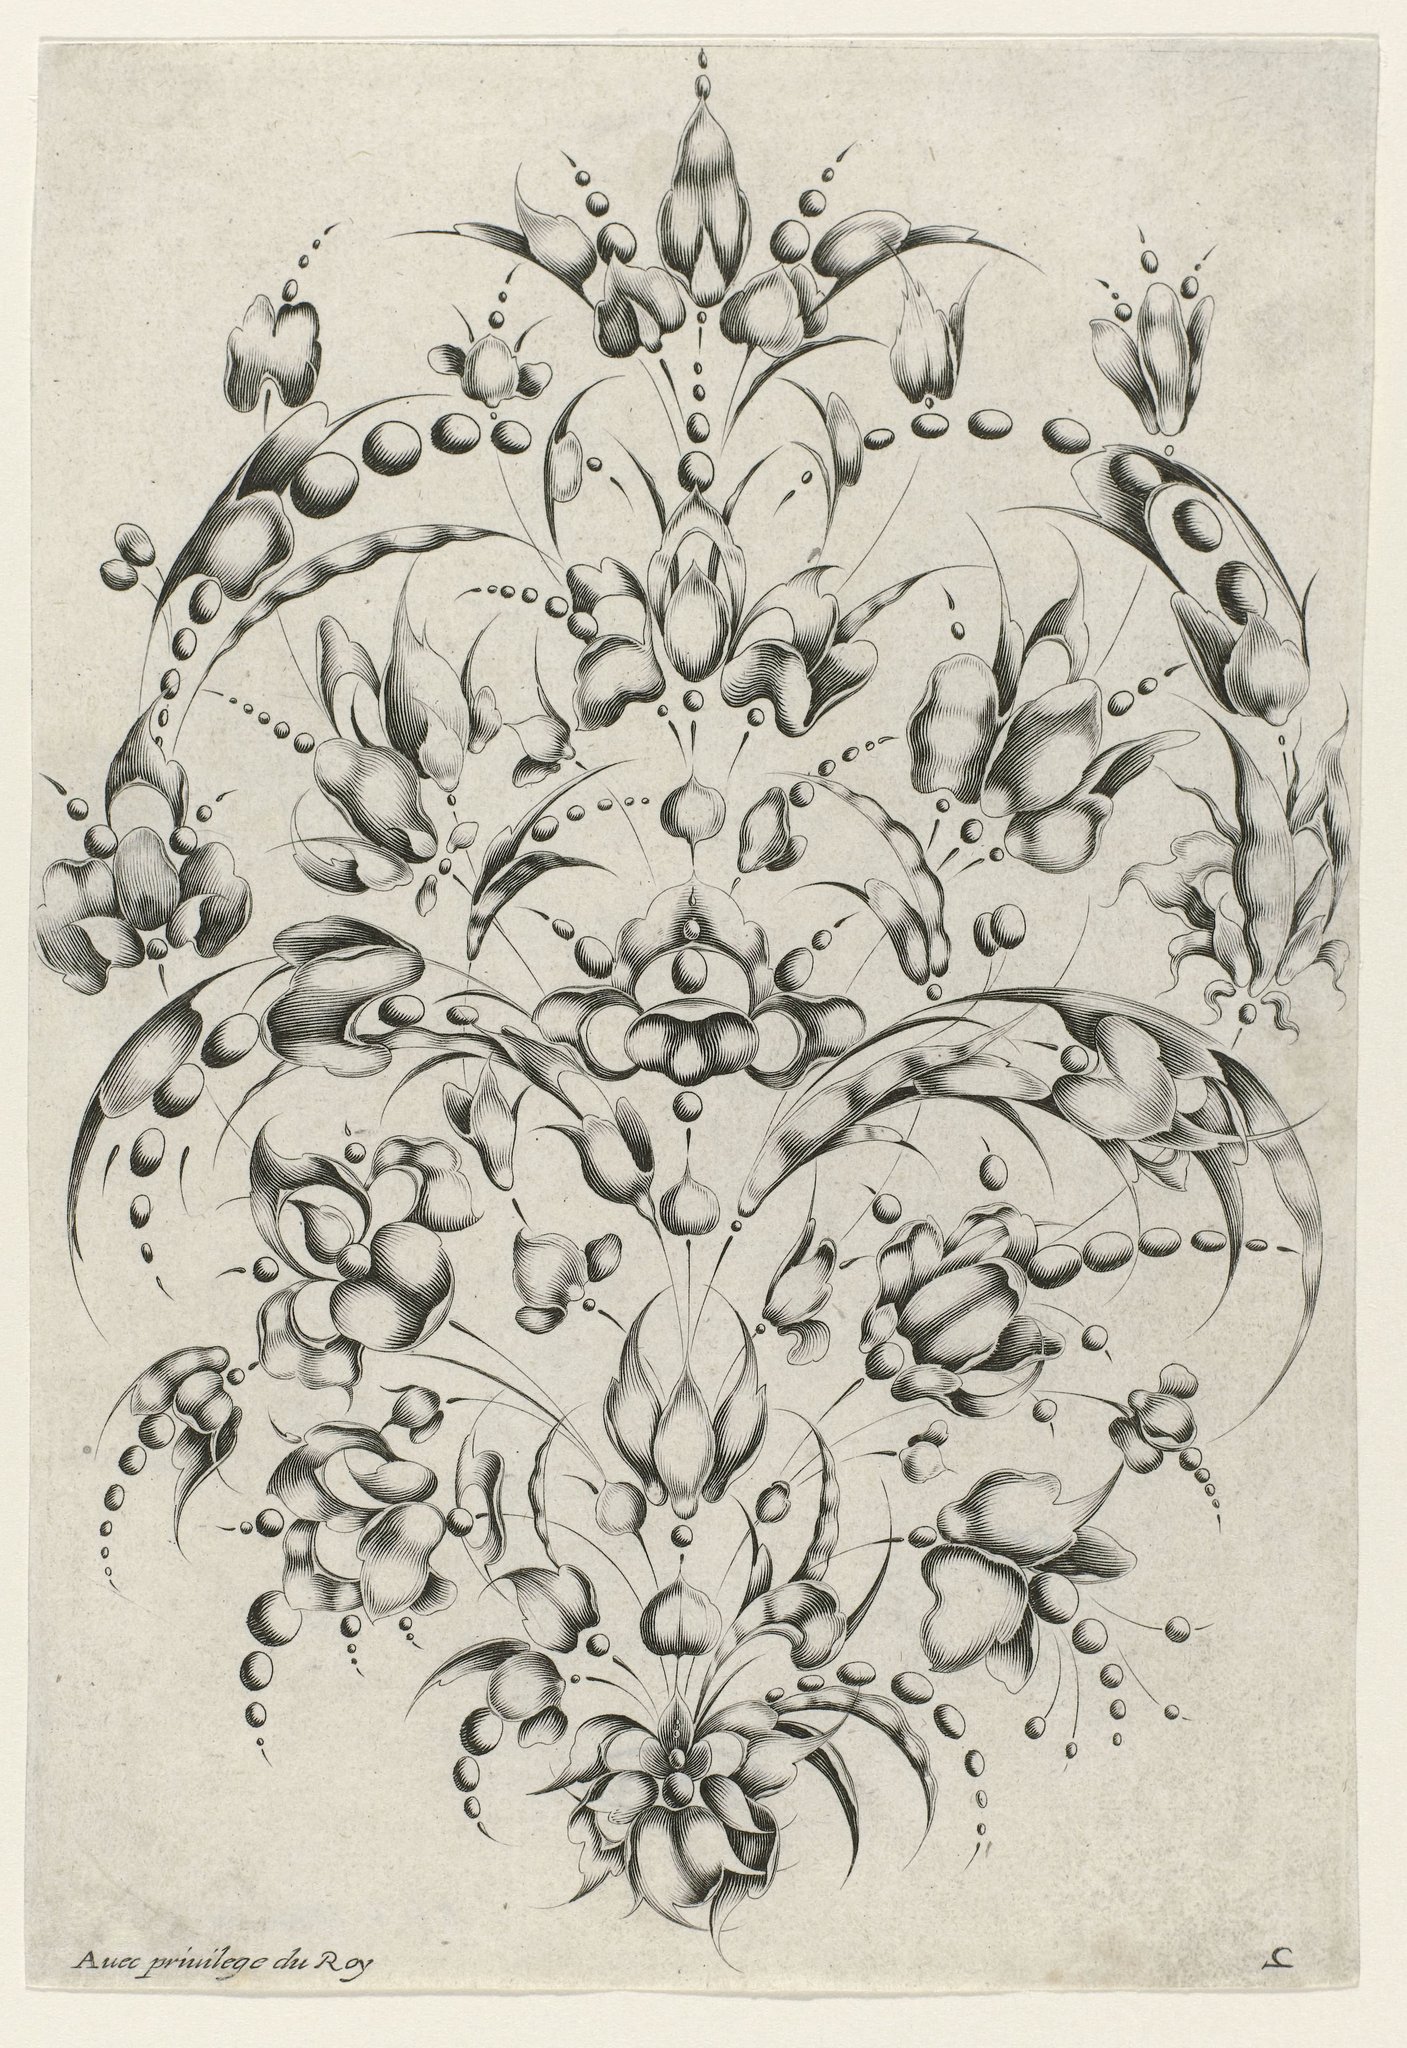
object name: print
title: Cosse-de-pois ornament voor goudsmeden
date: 1627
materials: paper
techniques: etching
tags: ornament derived from plant forms